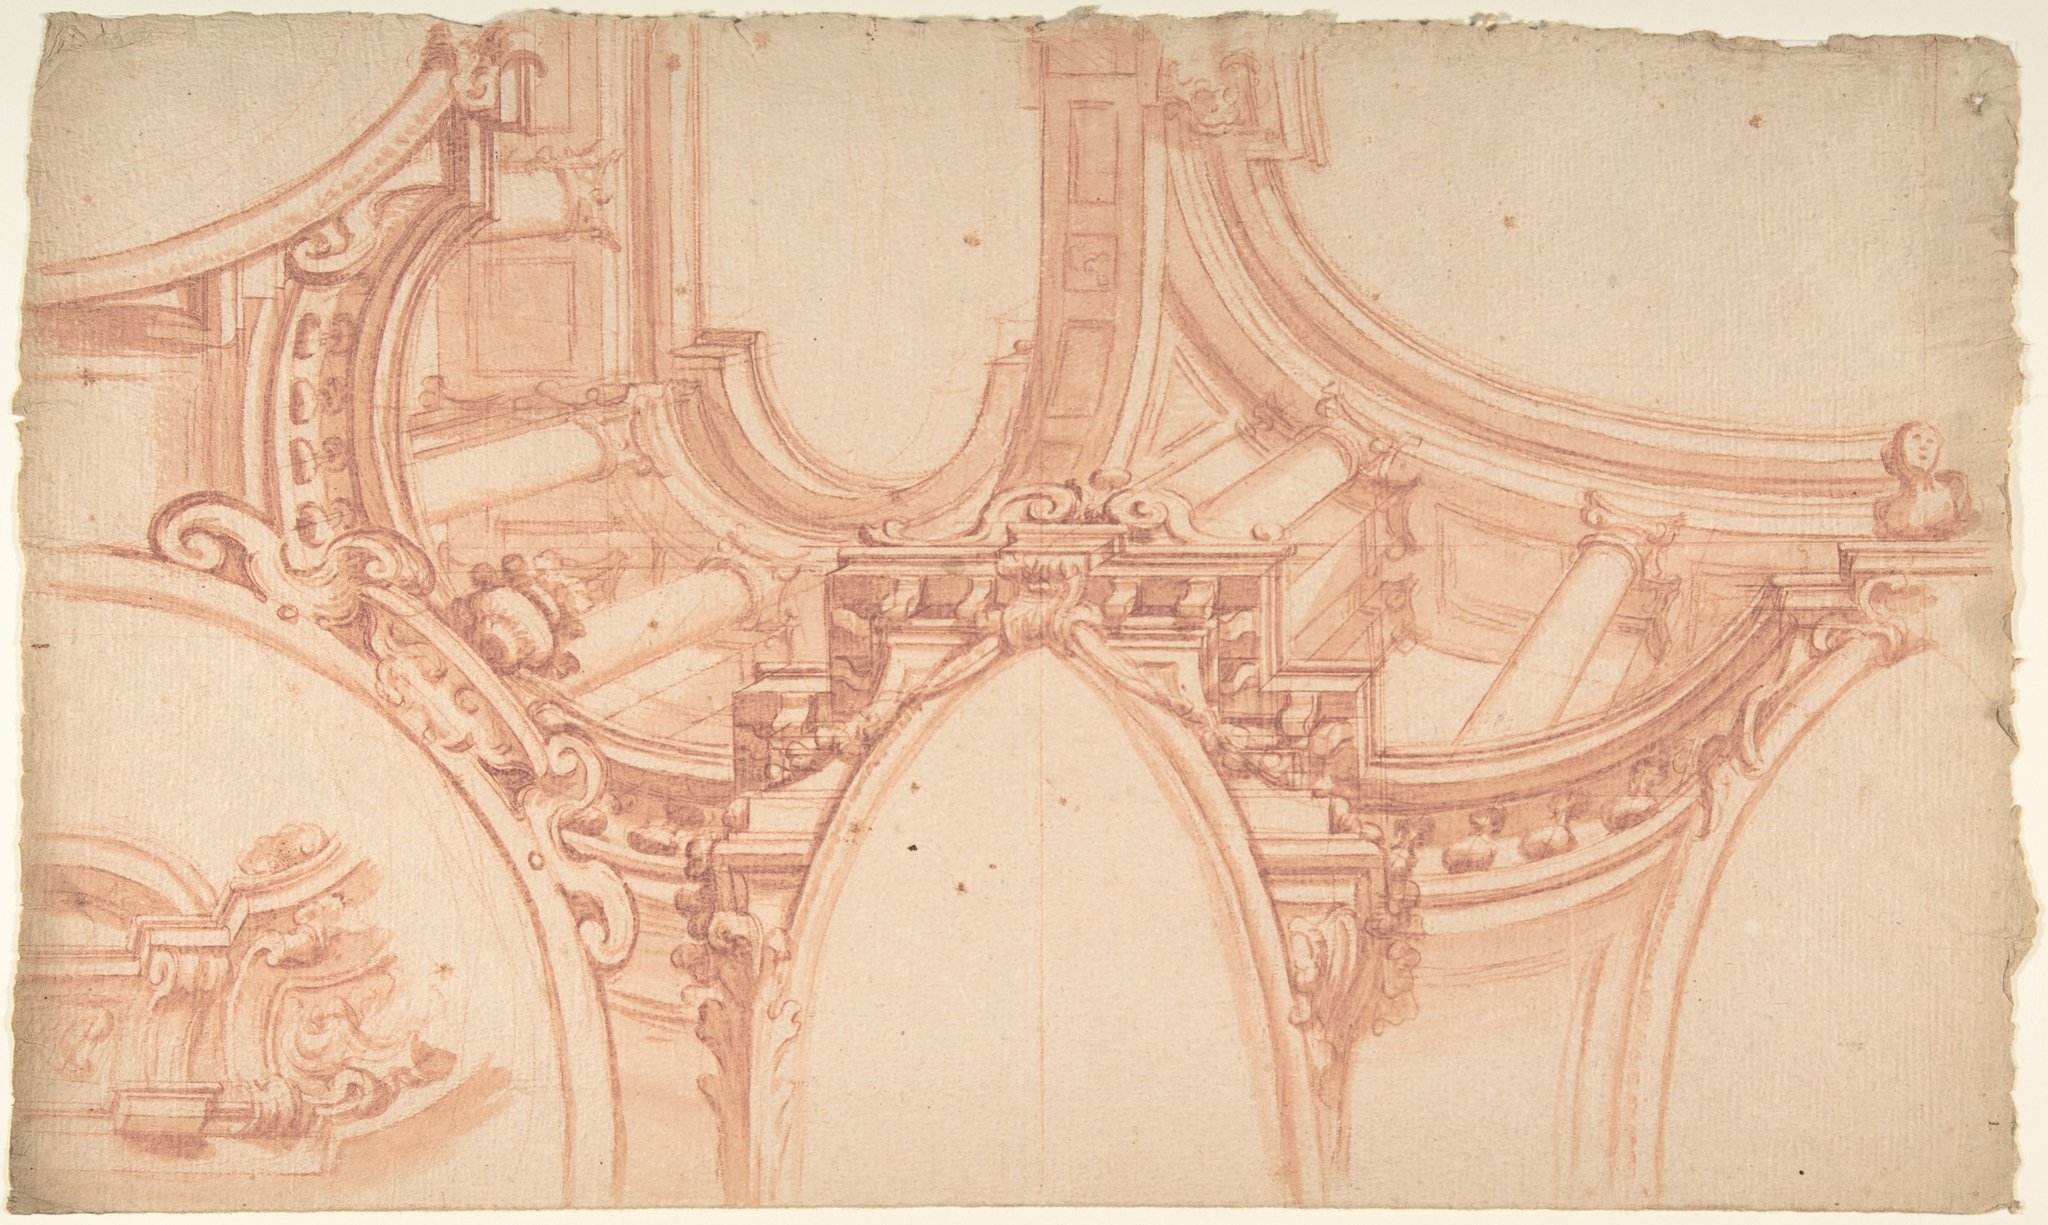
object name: drawing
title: Project for a painted ceiling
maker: anonymous, italian, piedmontese, 18th century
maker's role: artist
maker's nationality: italian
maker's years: 1700-1800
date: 1700-1780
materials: chalk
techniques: brush, wash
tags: architecture